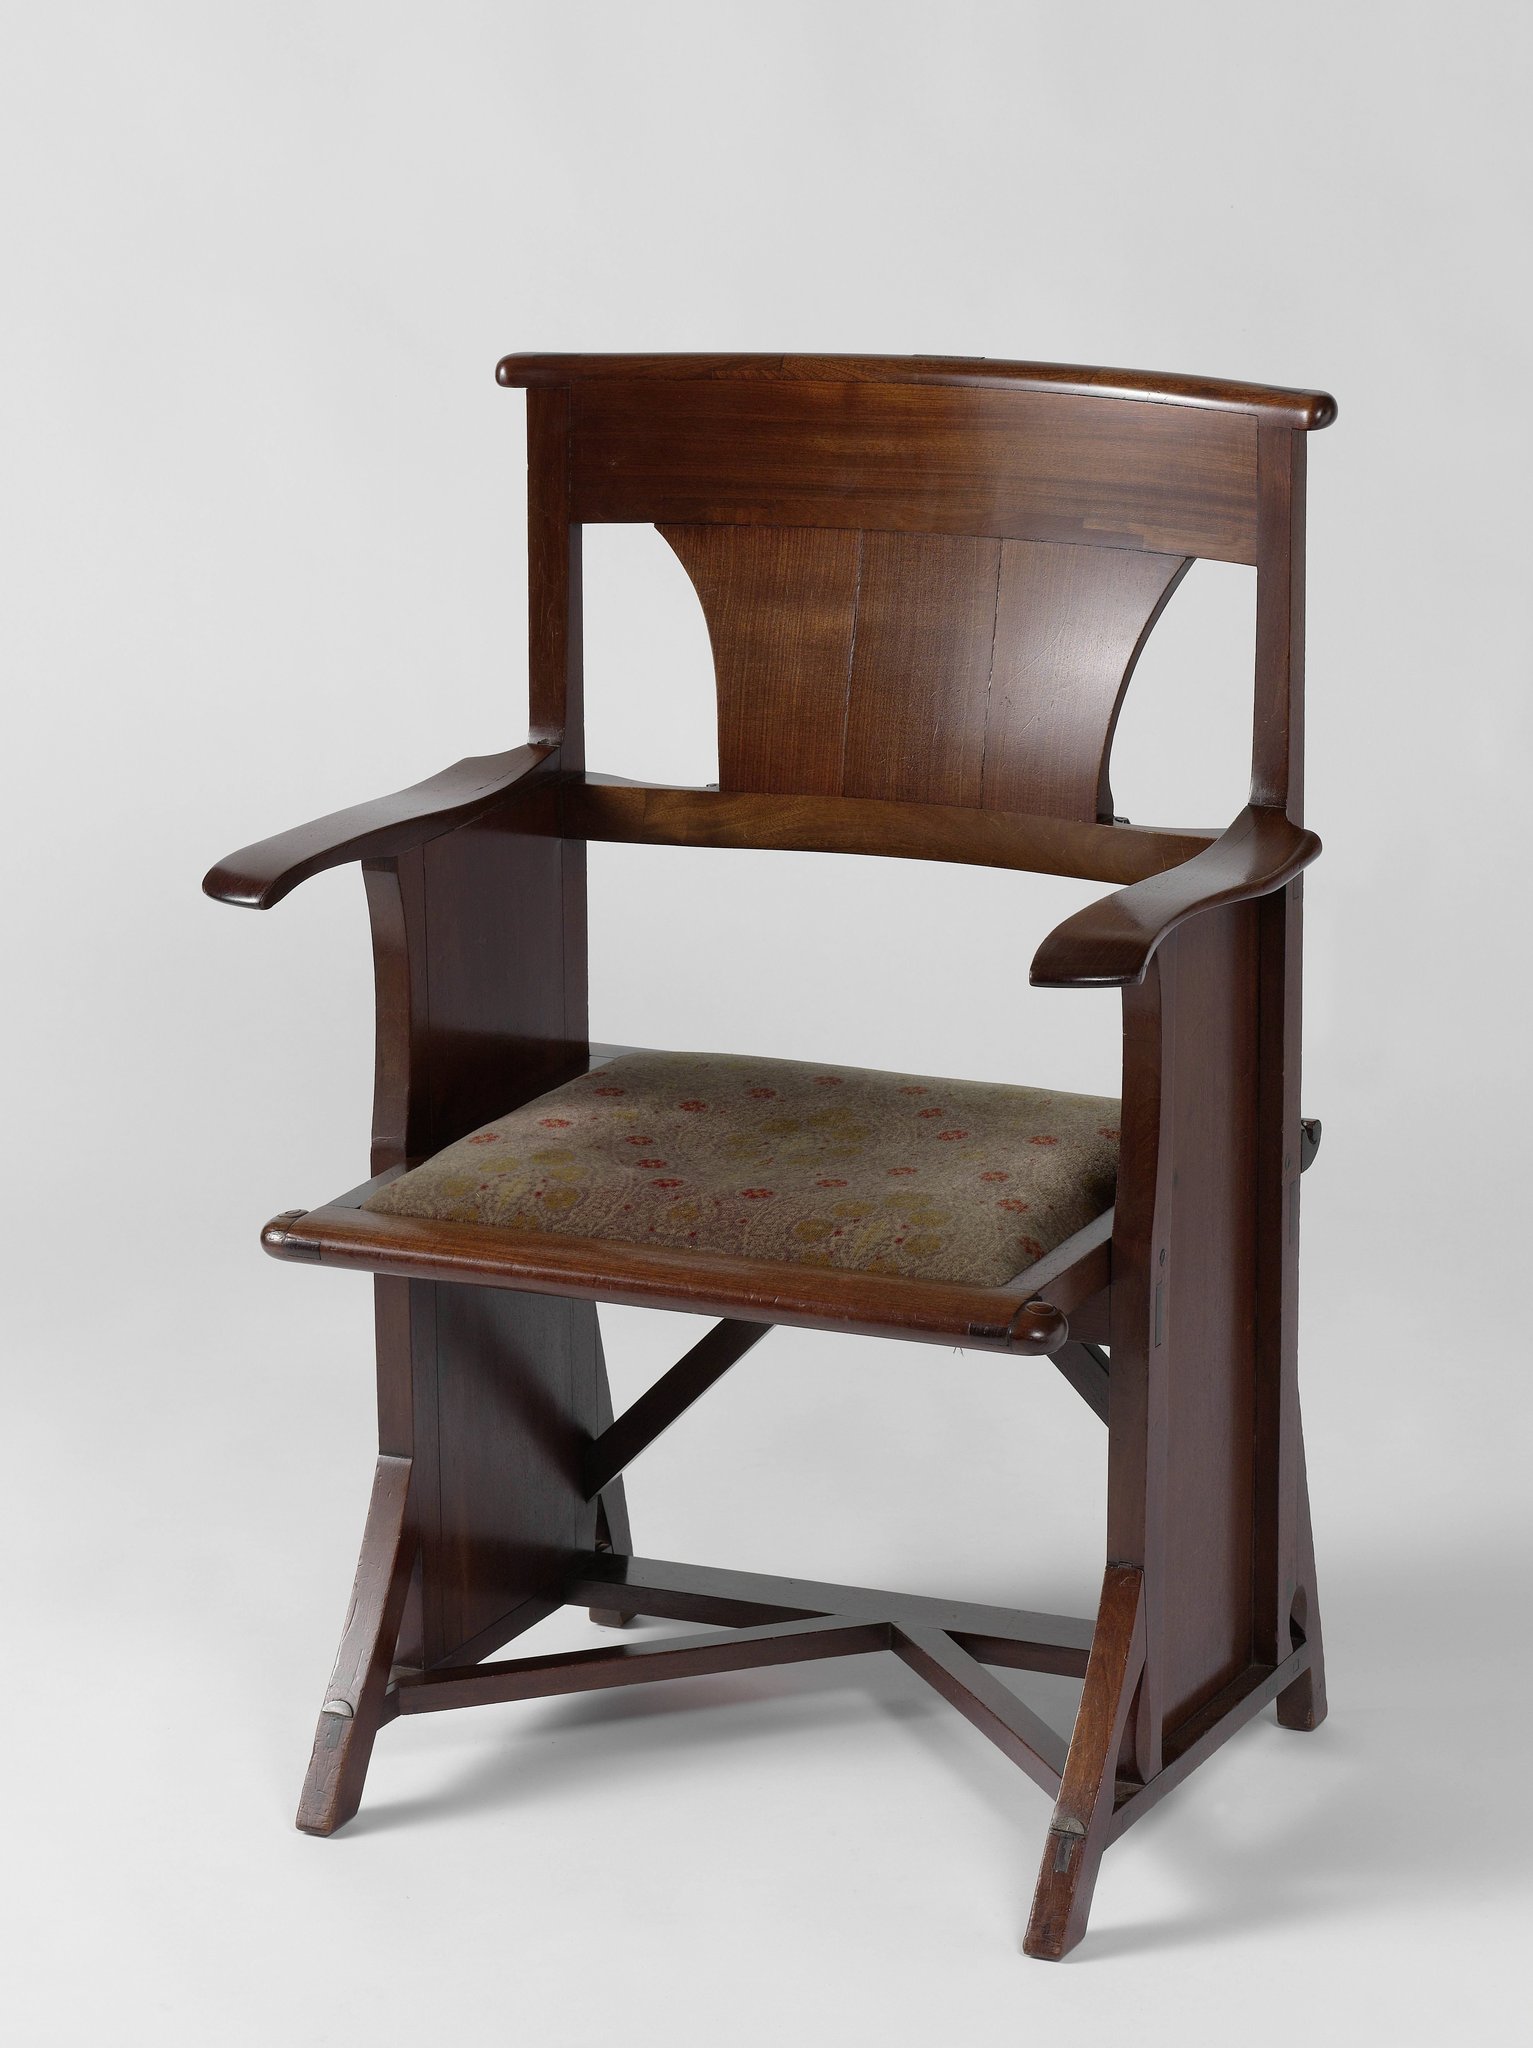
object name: armchair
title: Armstoel met hoge gesloten wangen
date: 1900-1905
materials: wood, brass, textile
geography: hengelo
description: Armstoel van mahoniehout met gesloten wangen rustend op schuingeplaatste poten. De schuingeplaatste poten zijn verbonden aan de vier stijlen en het K-vormig kruis dat de onderregels met elkaar verbindt. De voorpoten zijn aan de onderregels verbonden door middel van messing plaatjes met een halfronde kop. De stijlen lopen door in de licht geholde armstutten waarop enigszins golvende armleggers rusten. Het aan de voor- en achterzijde overhangende zitraam heeft op de hoeken aan de voorzijde een knop in de vorm van een slakkenhuis en op de hoeken aan de achterzijde een voluutvormige knop. Aan de achterzijde rust het zitraam op twee regels die tussen de twee stijlen zijn geplaatst, waarvan de achterste ondersteund wordt door twee stutten. De rug is door de drie regels in twee vlakken verdeeld. Het vlak aan de bovenzijde is gesloten, het vak aan de onderzijde heeft een brede, aan de zijkanten gebogen middenstijl opgebouwd uit drie delen. De bovendorpel steekt uit en eindigt in gebeeldhouwde knoppen.De lose zitting is bekleed met trijp waarop een gestileerde bloemen en ornamenten in beige, rood en geel.